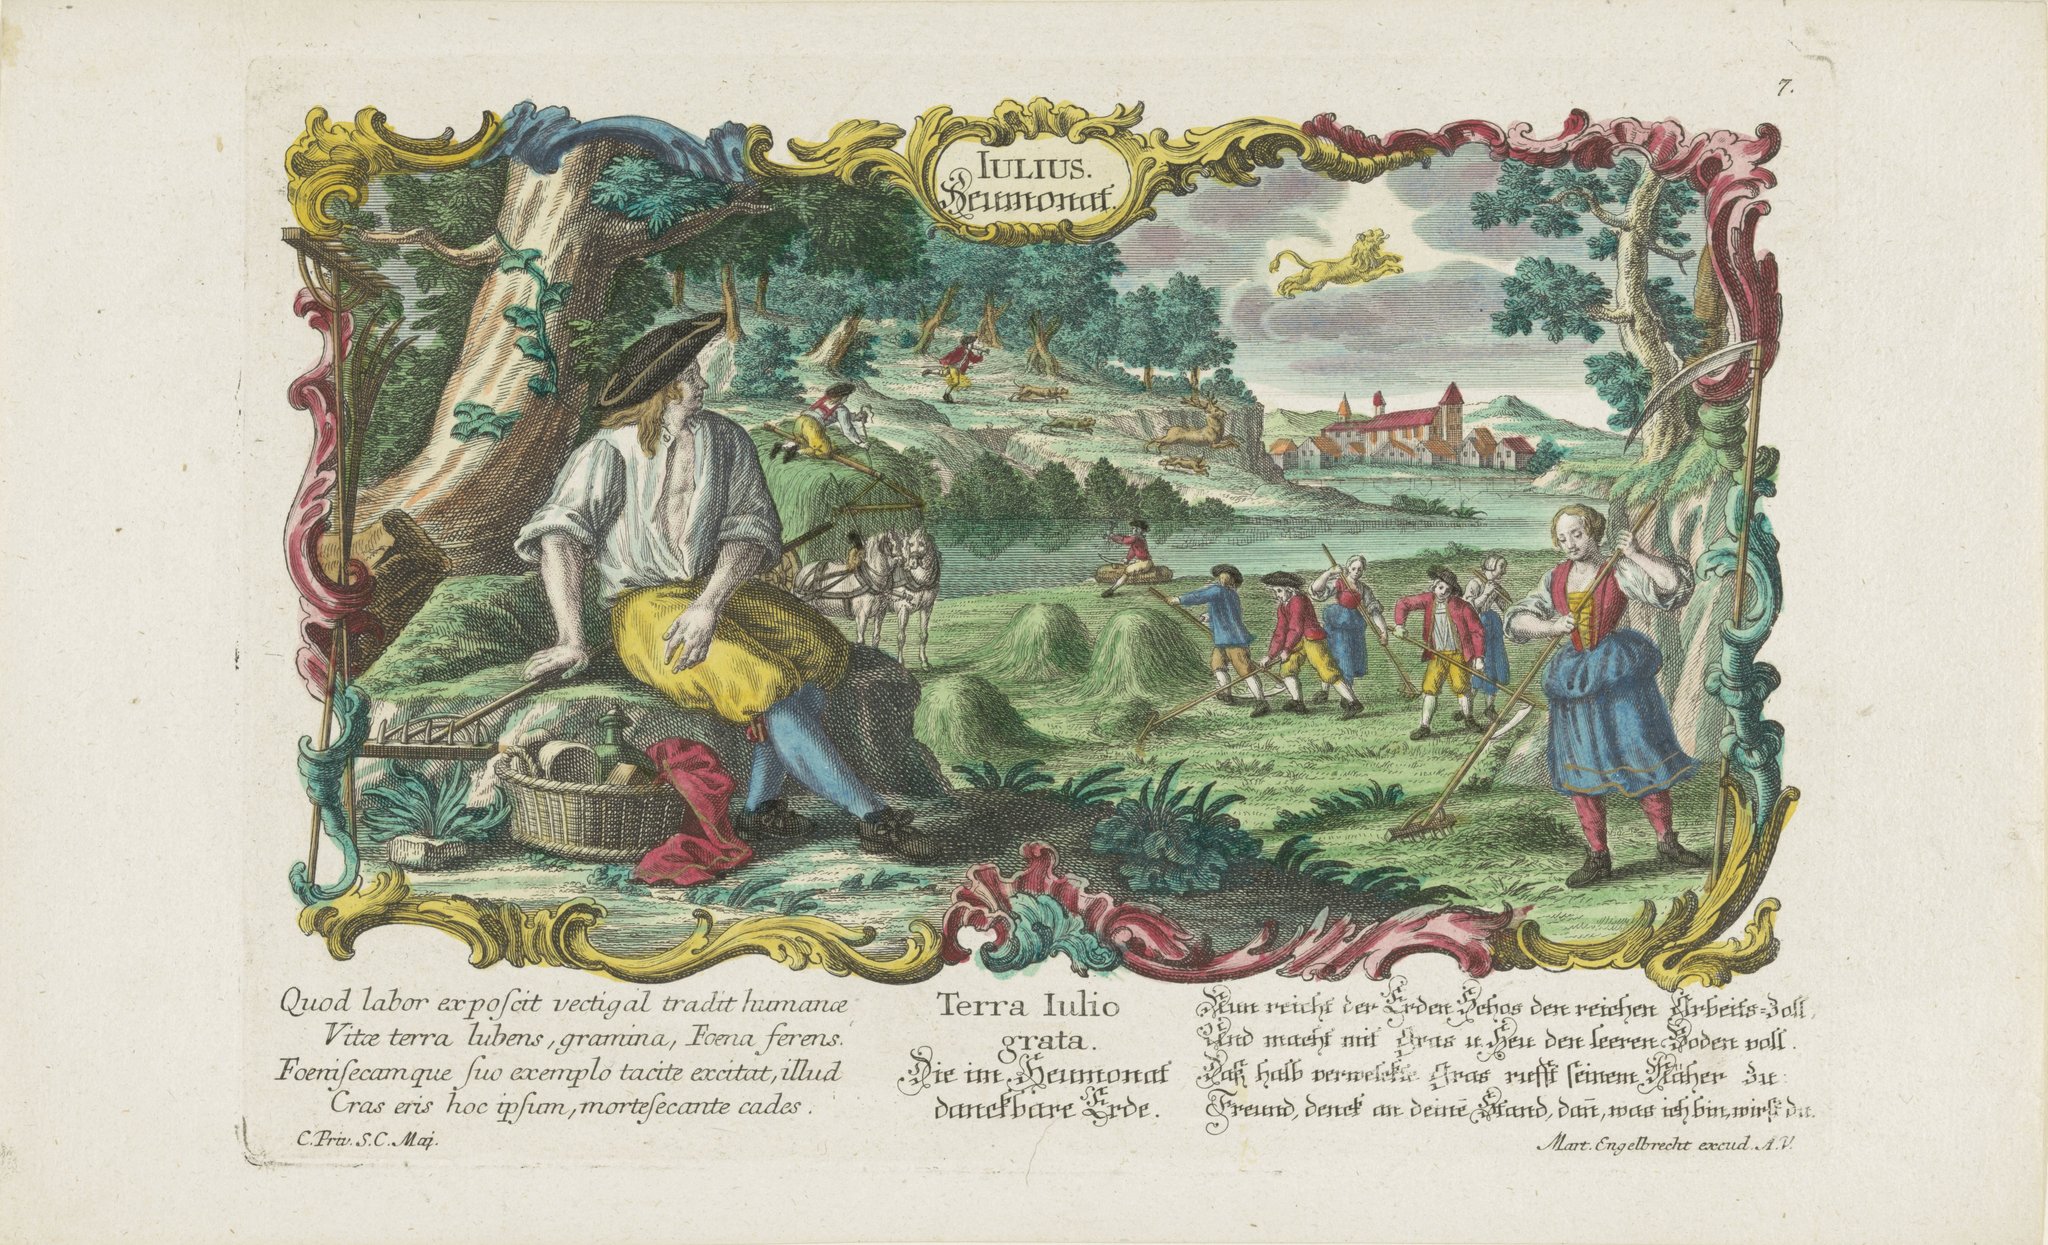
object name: print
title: De twaalf maanden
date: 1694-1756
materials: paper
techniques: etching, hand coloring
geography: augsburg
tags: agricultural products and by-products: hay (+ harvesting ~ agricultural processes), july and its 'labours' (+ with scenes showing human occupations ~ seasons and months), rest during harvest (eating, dancing, making love, etc.)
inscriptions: collector's mark: Lugt 2166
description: Een rustende hooier kijkt naar het veld achter hem waar mannen en vrouwen hooien. In de ondermarge twee keer een vierregelige tekst in het Latijn en Duits.